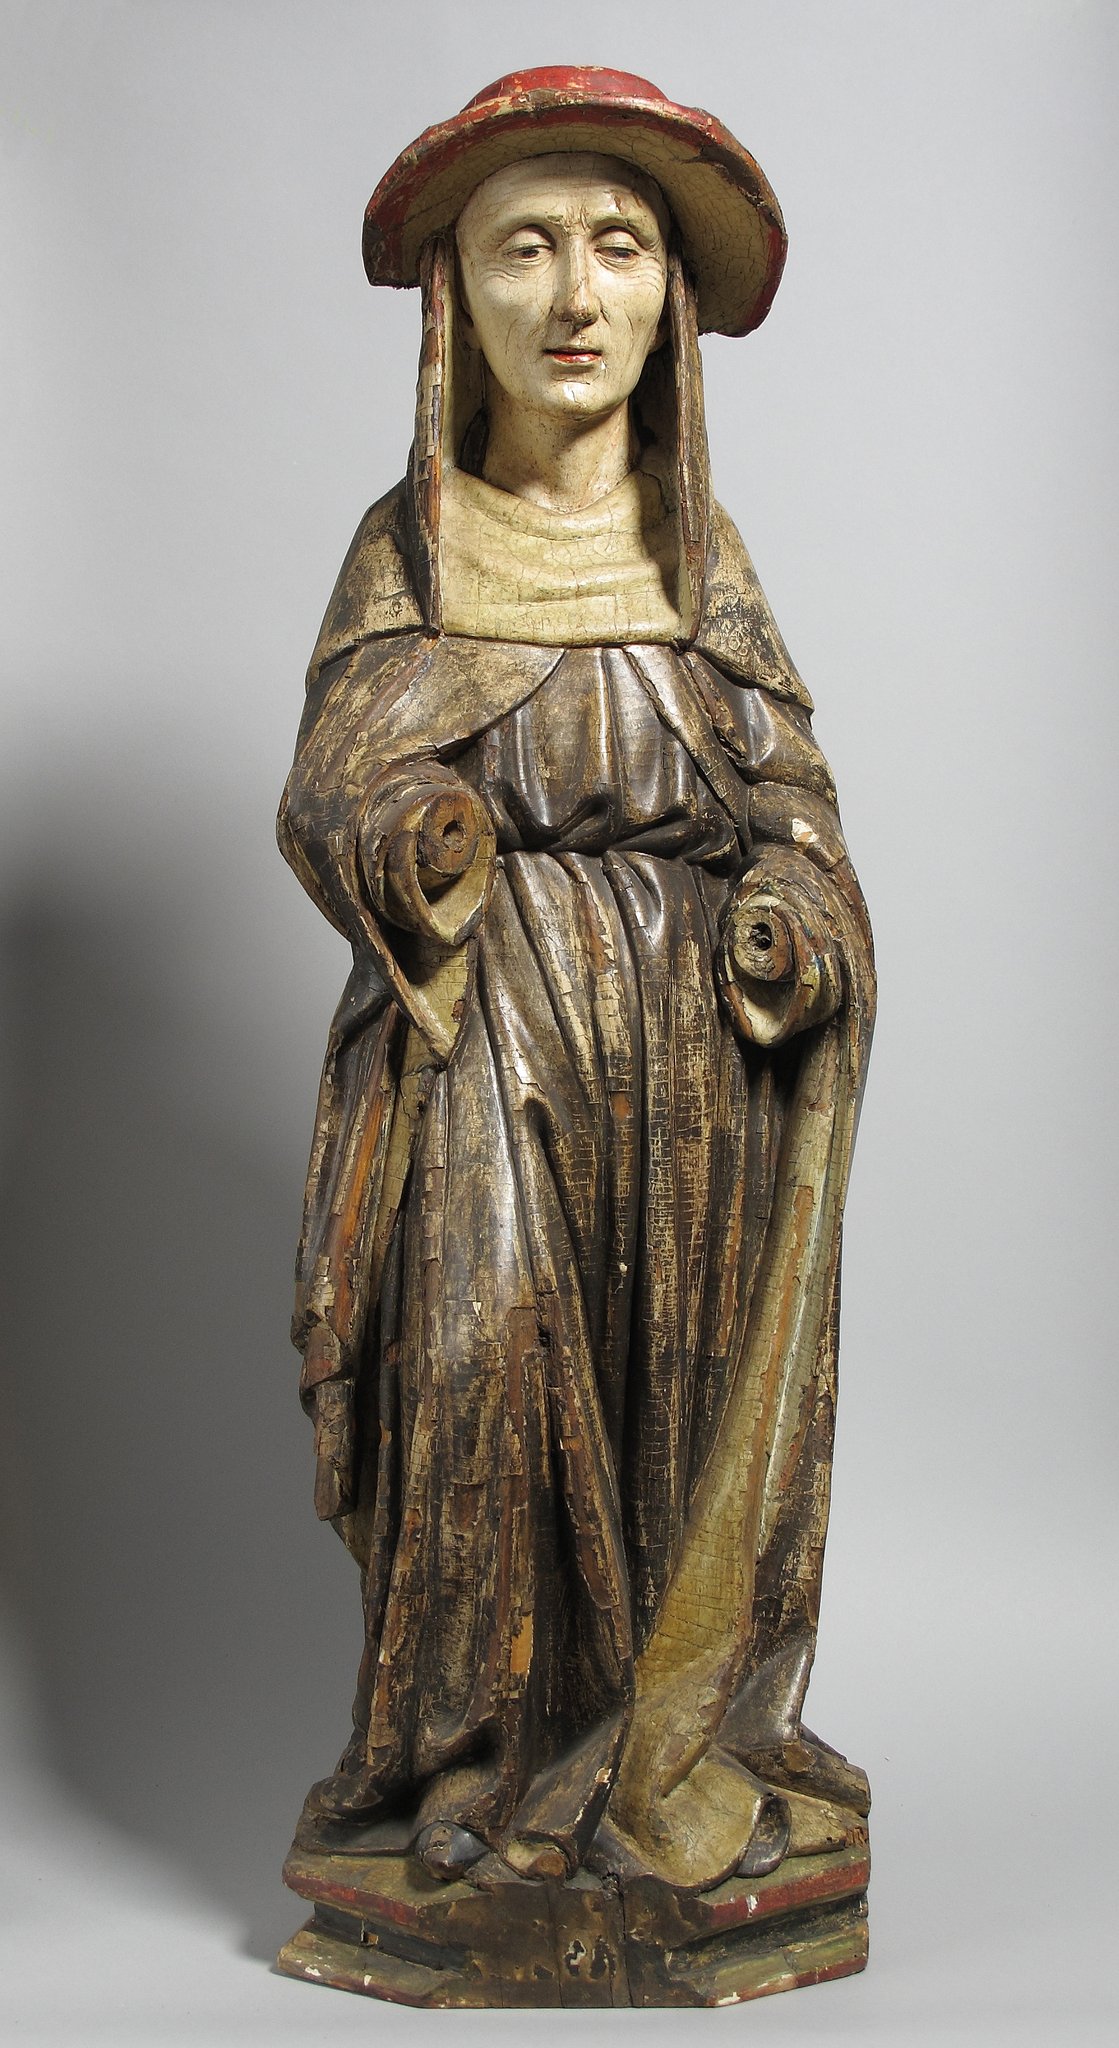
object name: statuette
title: Saint Jerome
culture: austrian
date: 1401-1500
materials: paint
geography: austria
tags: men,saint jerome